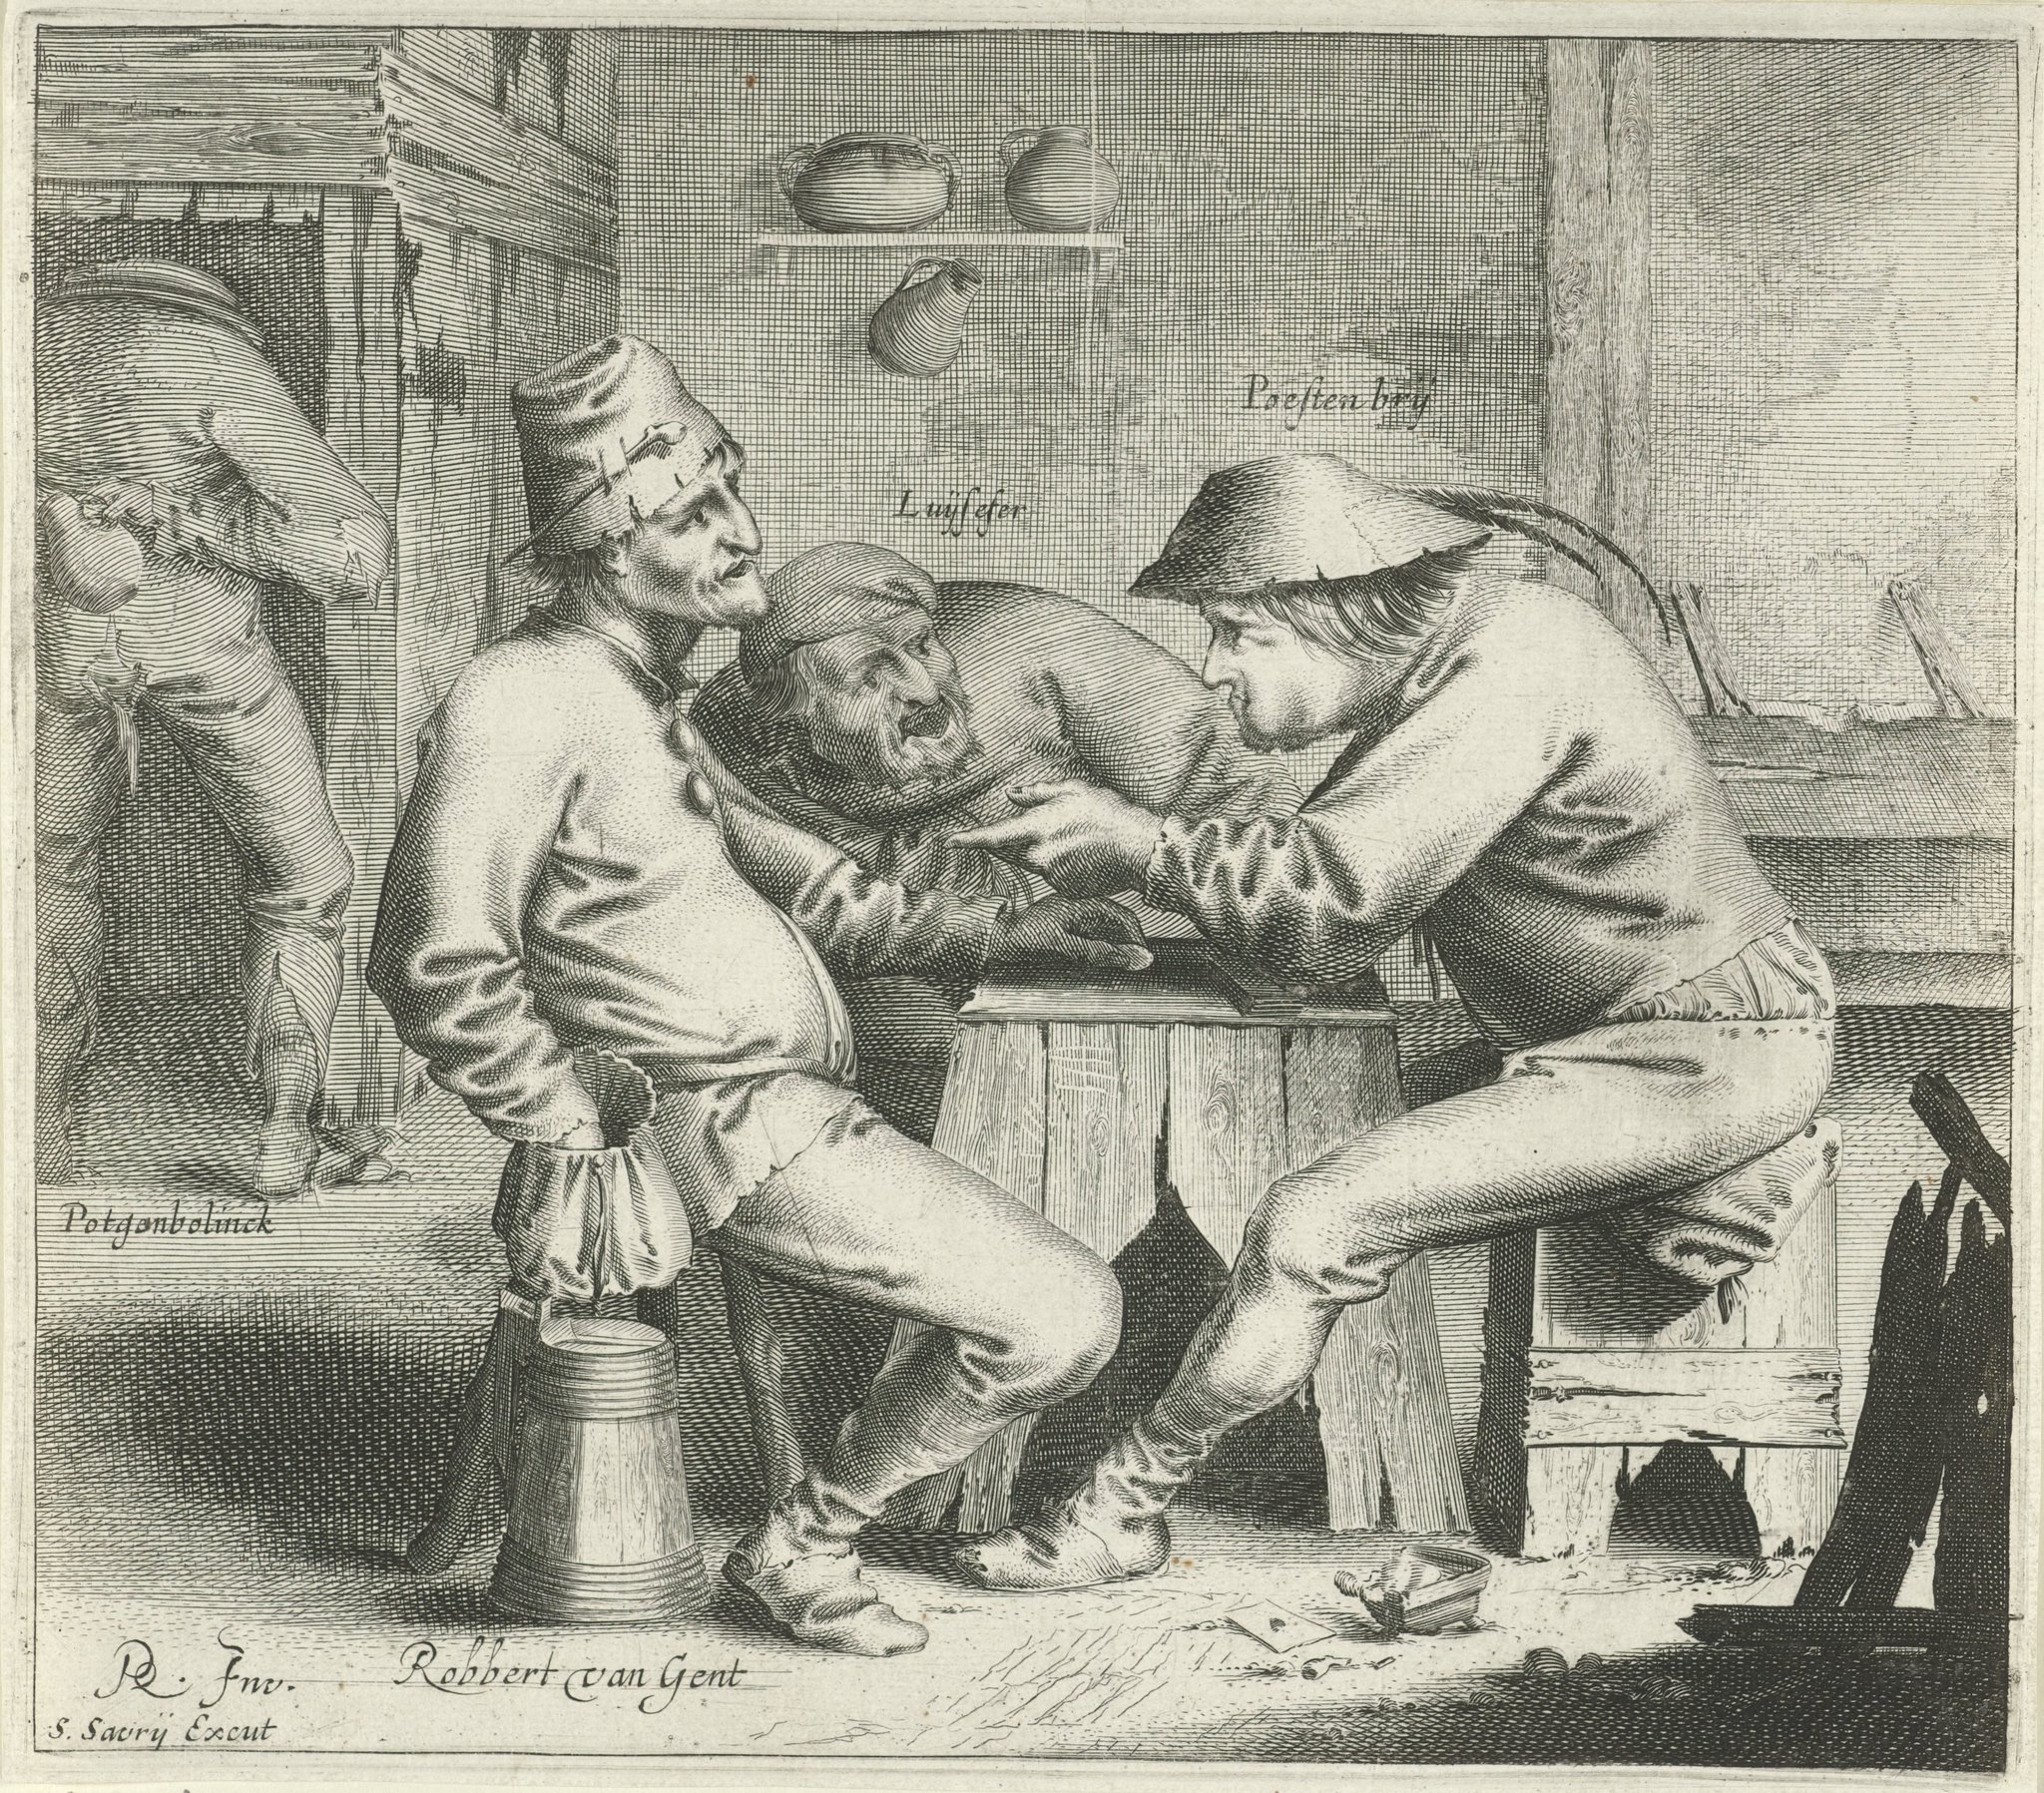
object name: print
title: Herberg met drie mannen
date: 1630-1678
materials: paper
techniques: engraving, etching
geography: netherlands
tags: purse, money-bag, pipe ~ tobacco, jar, jug (used as drinking-vessel), card games, hotel, hostelry, inn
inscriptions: collector's mark: Lugt 240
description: In een herberg zitten Robbert van Gent, Luijseveer, Poestenbrij rond een tafel te praten en een spel te spelen. Van Gent graait in zijn geldbuidel terwijl Poestenbrij naar hem wijst. Op de grond ligt een speelkaart en een gebroken pijpje. Links staat Potgenbolinck met de rug naar de toeschouwer gekeerd. Tegen de muur een plankje met bierkannen.